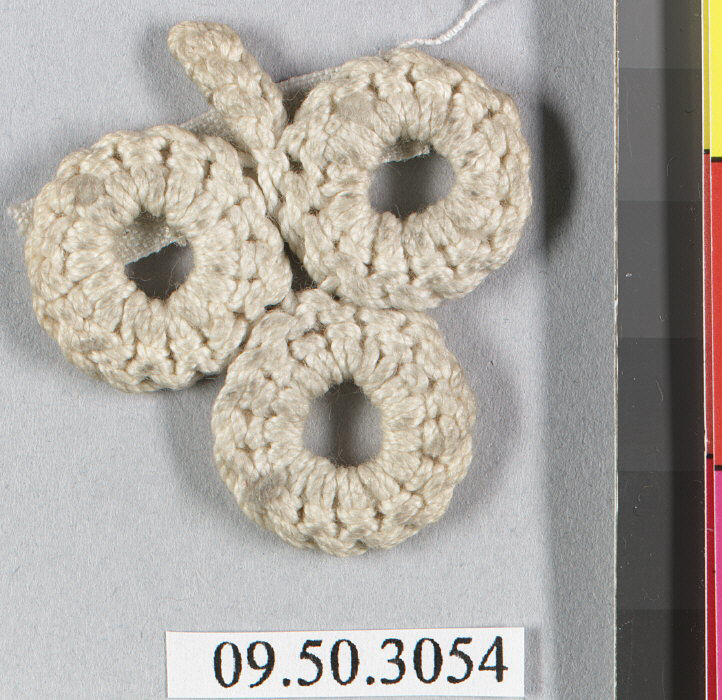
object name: sample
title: Crochet Work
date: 1801-1900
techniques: crochet